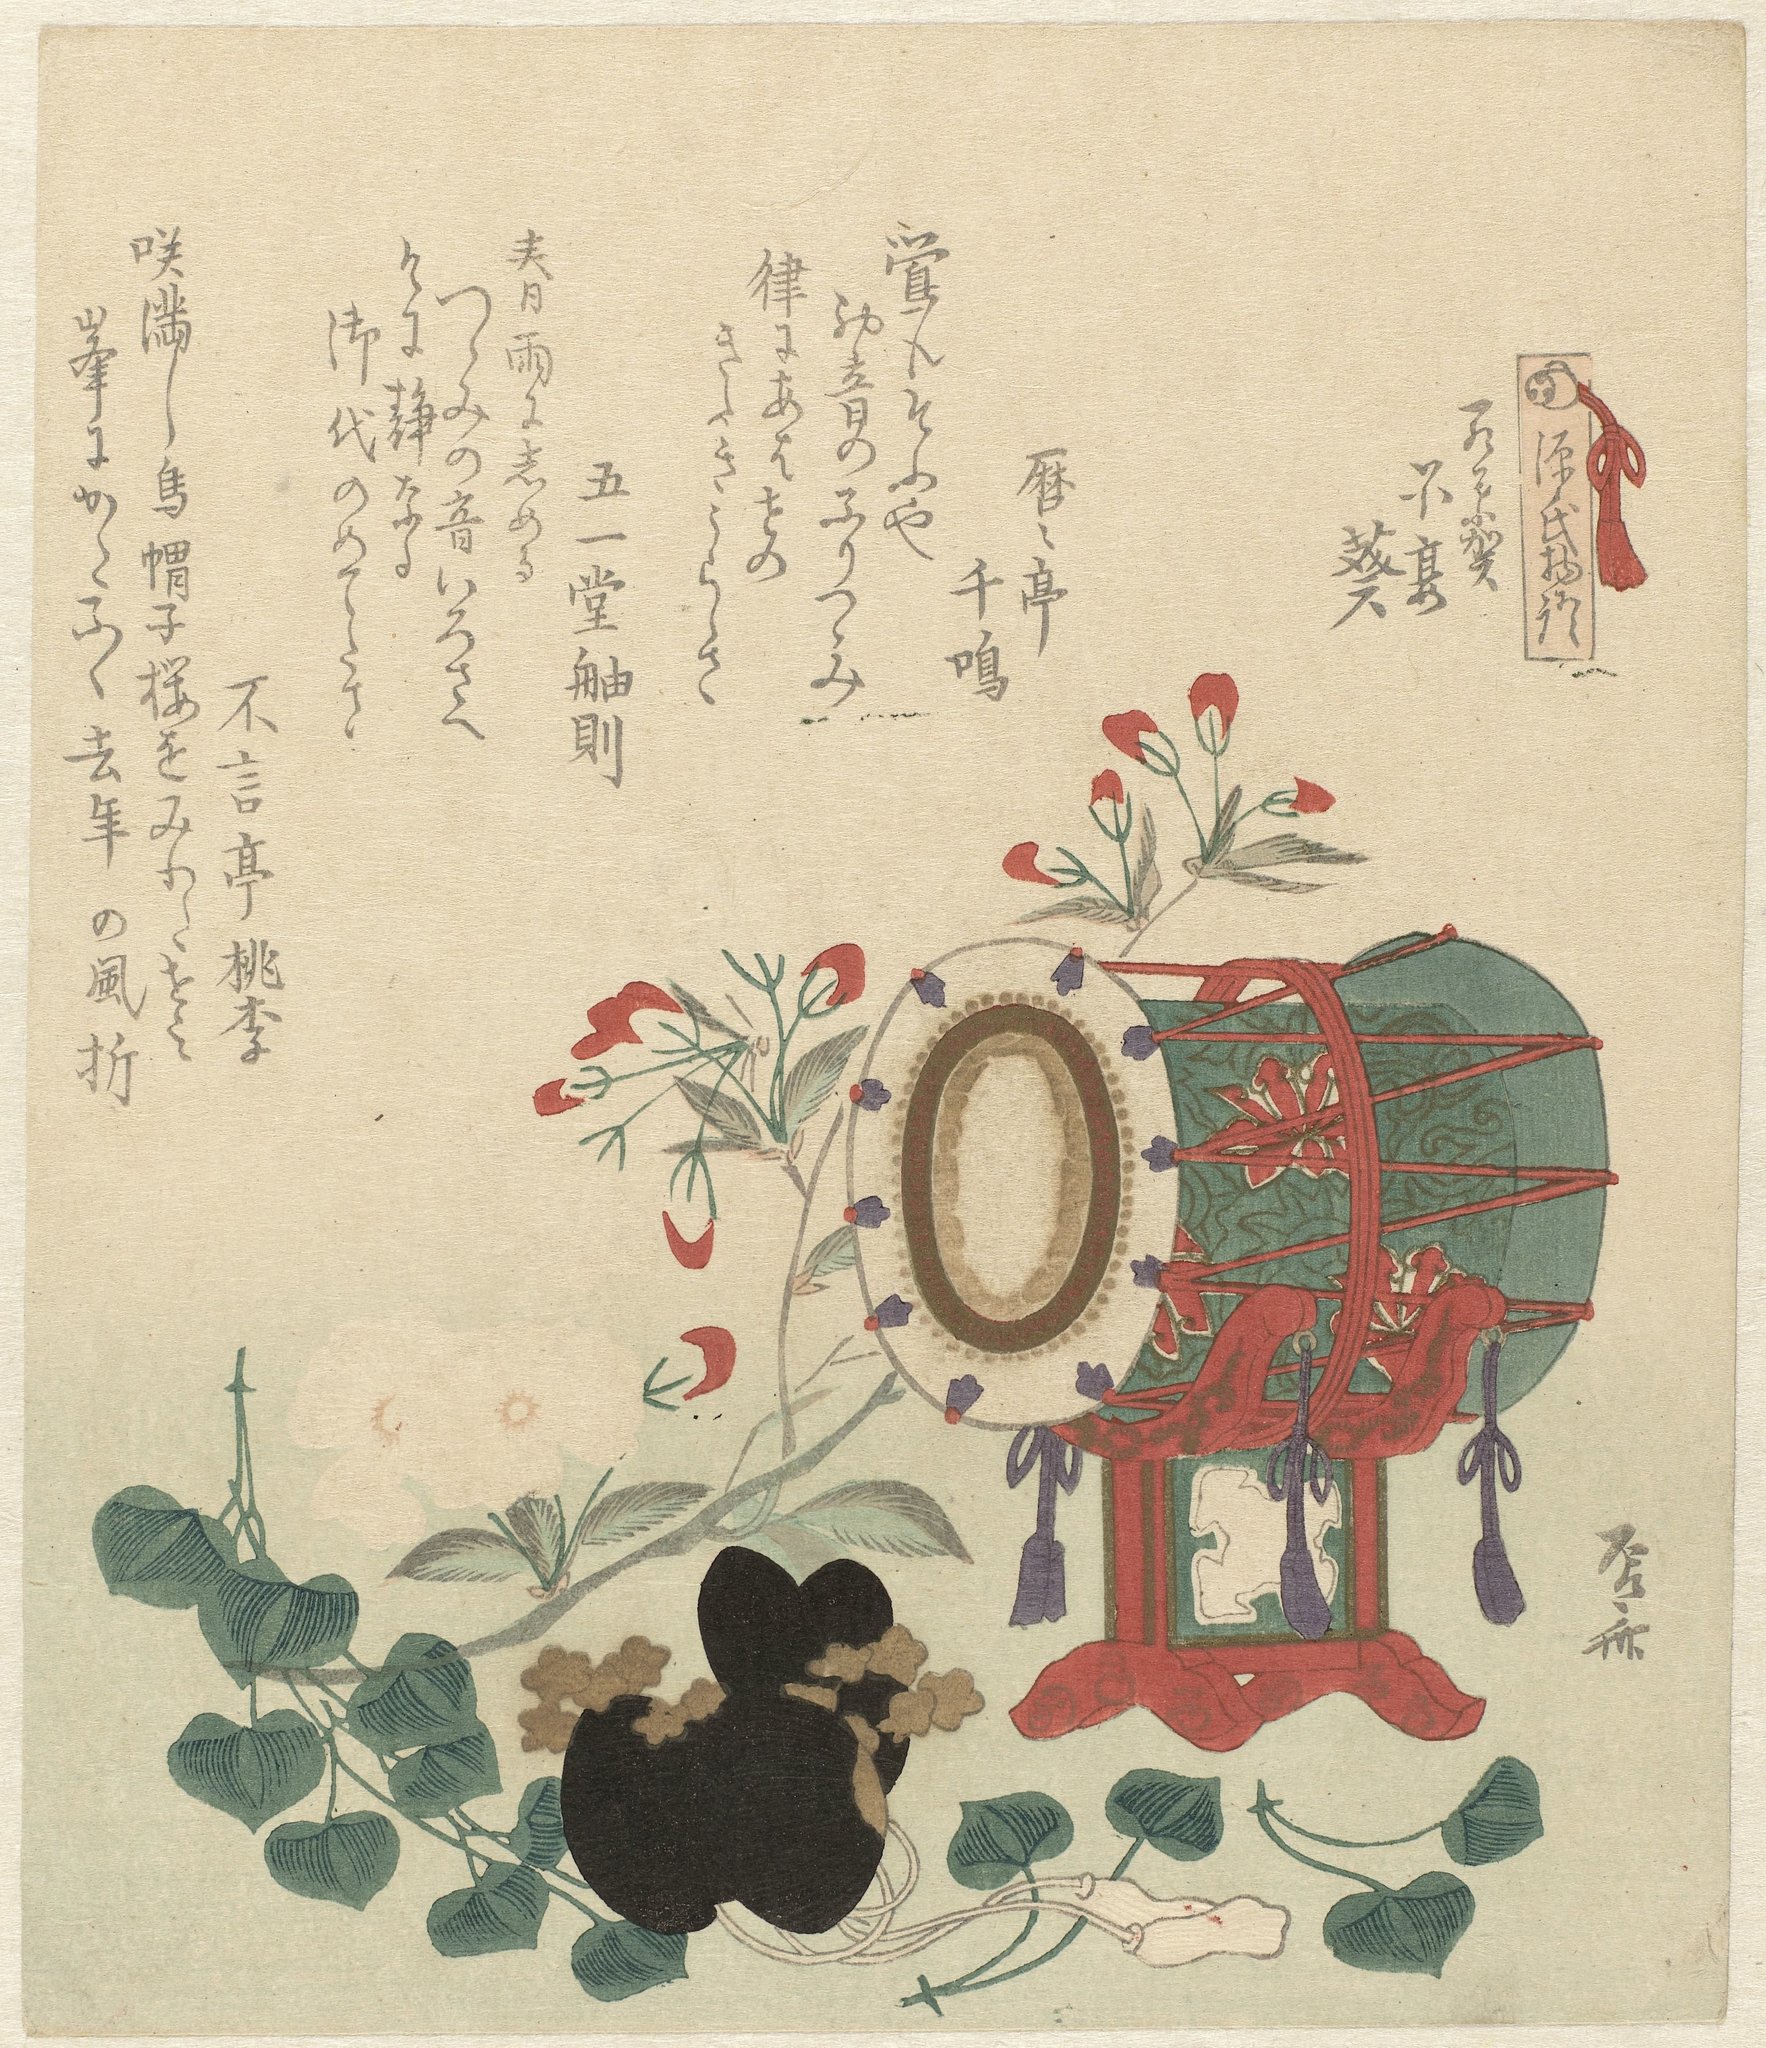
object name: print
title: Trommel, hofmuts en bloemen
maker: ryûryûkyo shinsai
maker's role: draughtsman, print maker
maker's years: 1764-1825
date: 1890-1900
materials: paper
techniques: blind stamped, woodcut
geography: japan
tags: drum (musical instrument)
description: Een surimono is een luxe uitgevoerde prent waarop beeld met één of meerdere gedichten gecombineerd is. Bij het drukken van een surimono werd vaak gebruik gemaakt van dikker papier, blinddruk en metaal pigmenten, zoals koper- en zilverpoeder. De prenten werden vaak in opdracht van dichters gemaakt en als exclusief geschenk aan vrienden en relaties gegeven.